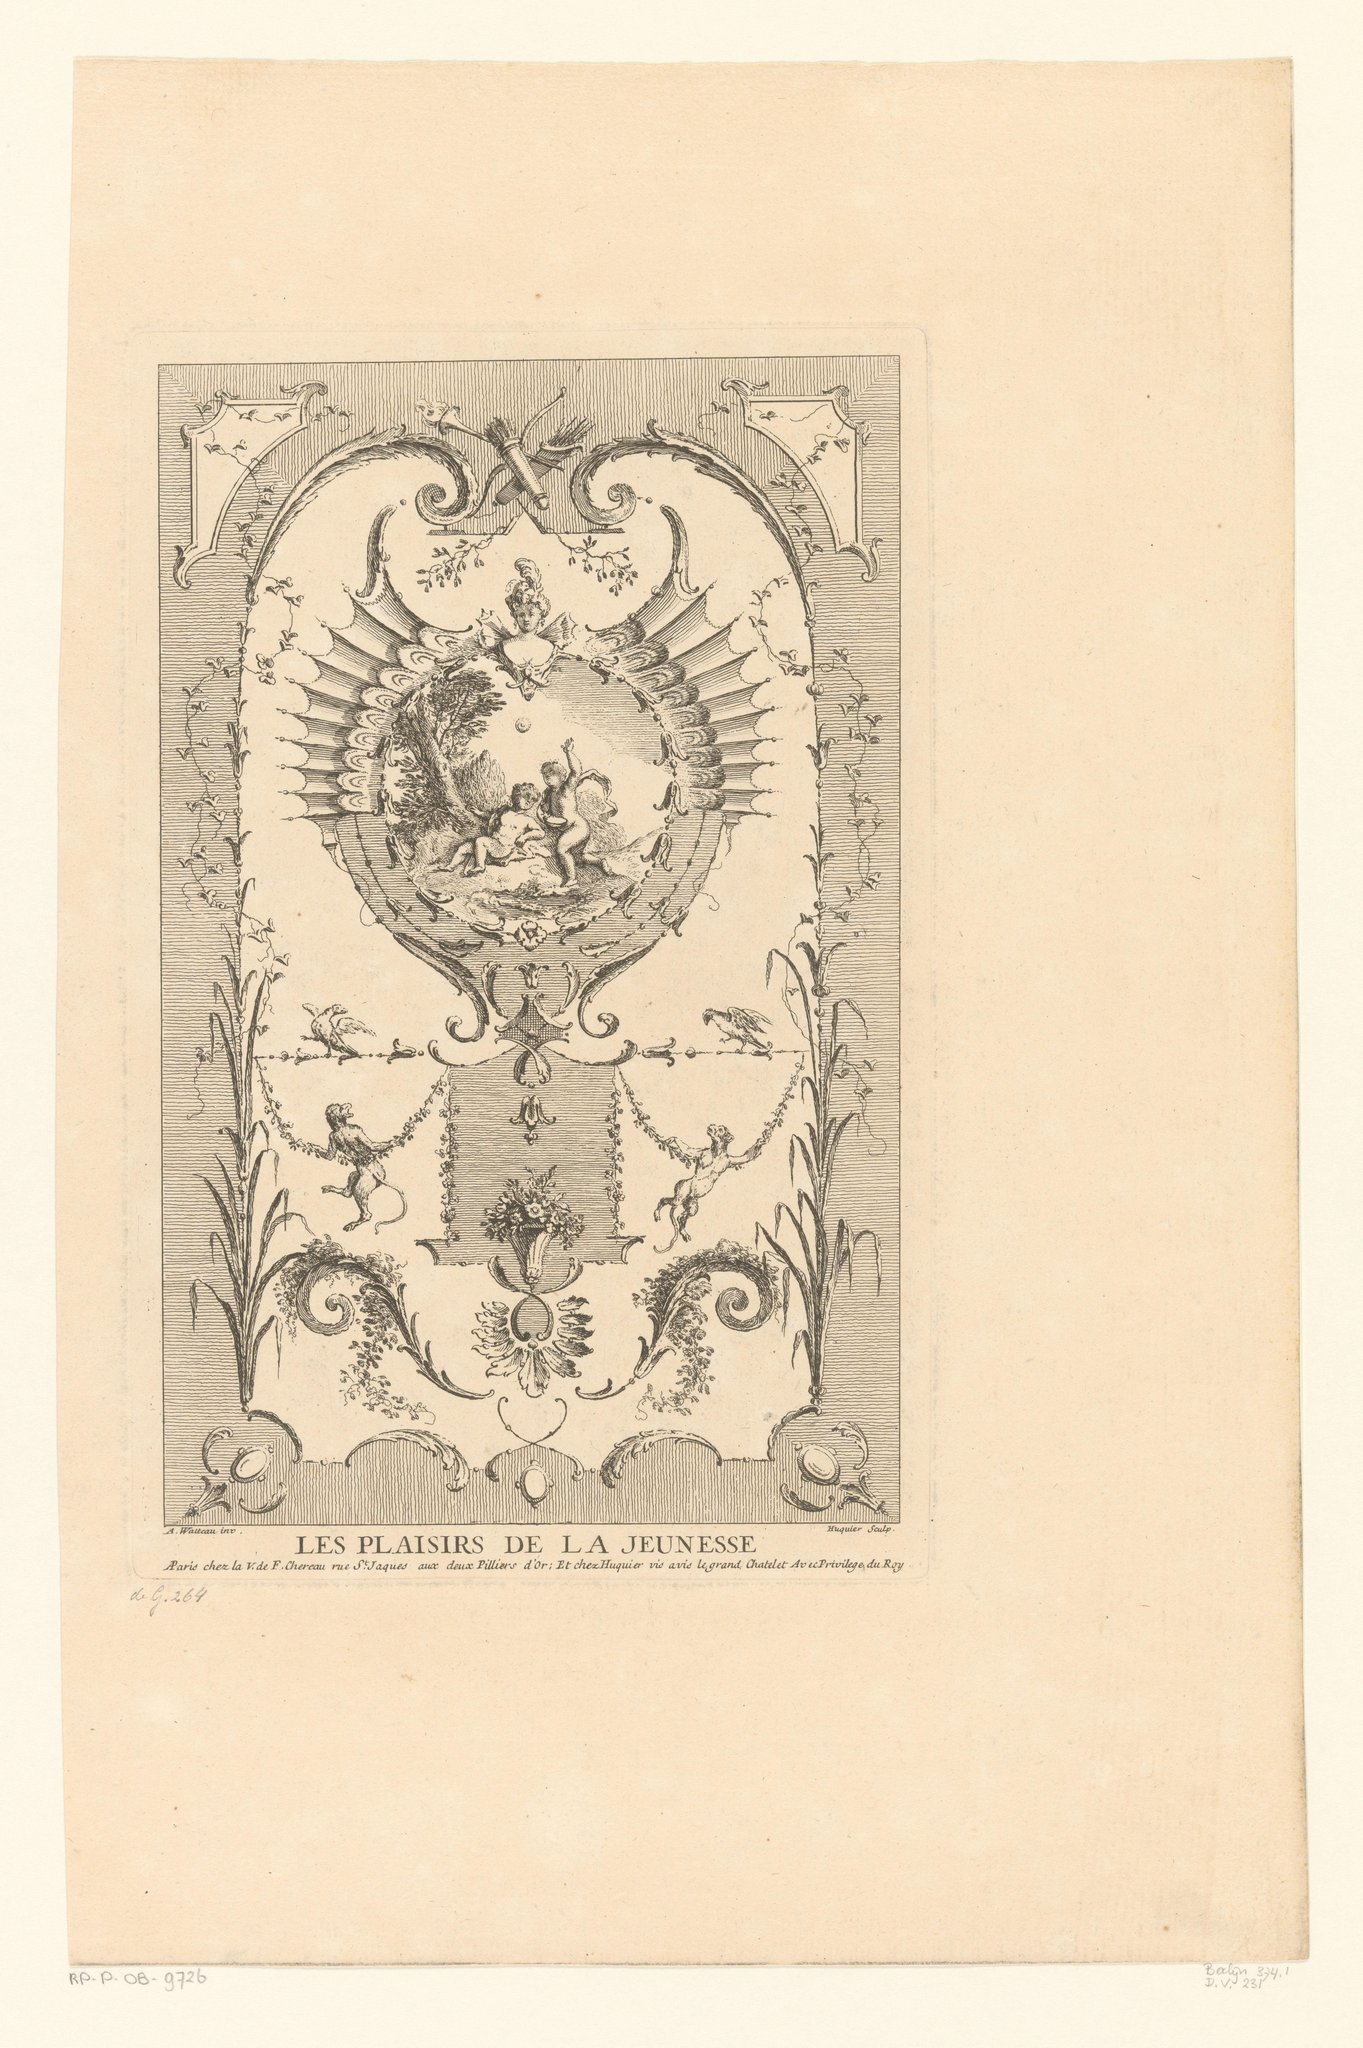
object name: ornament print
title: Les Plaisirs De La Jeunesse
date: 1729-1737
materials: paper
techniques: etching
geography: paris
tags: children's games and plays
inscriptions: collector's mark: Lugt 2228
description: In een medaillon zitten twee spelende kinderen in een landschap. Rondom de voorstelling een omlijsting met rocailles, bladmotieven, een trofee met pijlenkokers, boog en fakkel, vogels en apen.